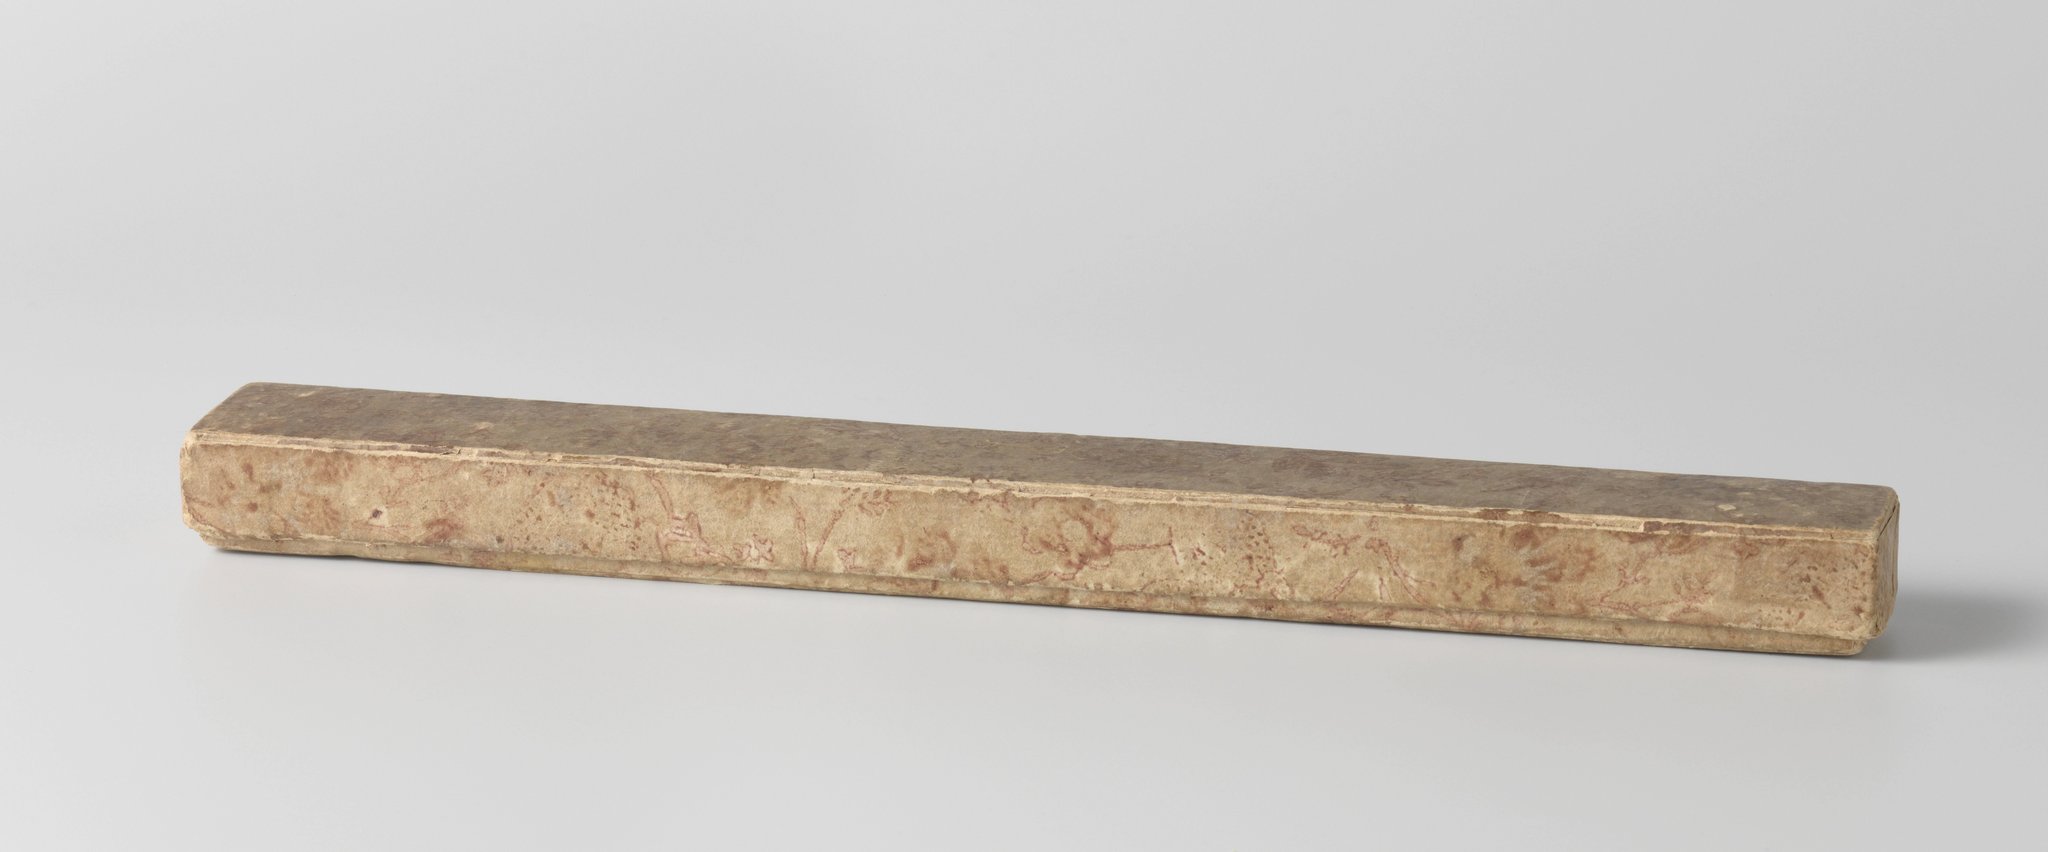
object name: packing material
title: Waaierdoos van karton beplakt met sierpapier met een wit fond waarop paarsbruine bloemen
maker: Anonymous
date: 1740-1750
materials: cardboard, paper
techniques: printing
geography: netherlands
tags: amsterdam, painter, gijs bosch reitz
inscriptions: inscription: ‘Aan Catharina Isabella Six, van haar groetmoeder en peet, Catharina Isabella Bosch Reitz-Teding van Berkhout, en hare bet-overgrootmoeder Catharina Isabella Teding van Berkhout-Low.’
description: In het deksel van de waaierdoos met de hand met inkt geschreven: 'Aan Catharina Isabella Six, van haar grootmoeder en peet, Catharina Isabella Bosch Reitz-Teding van Berkhout, en hare bet-overgrootmoeder Catharina Isabella Teding van Berkhout-Low.'